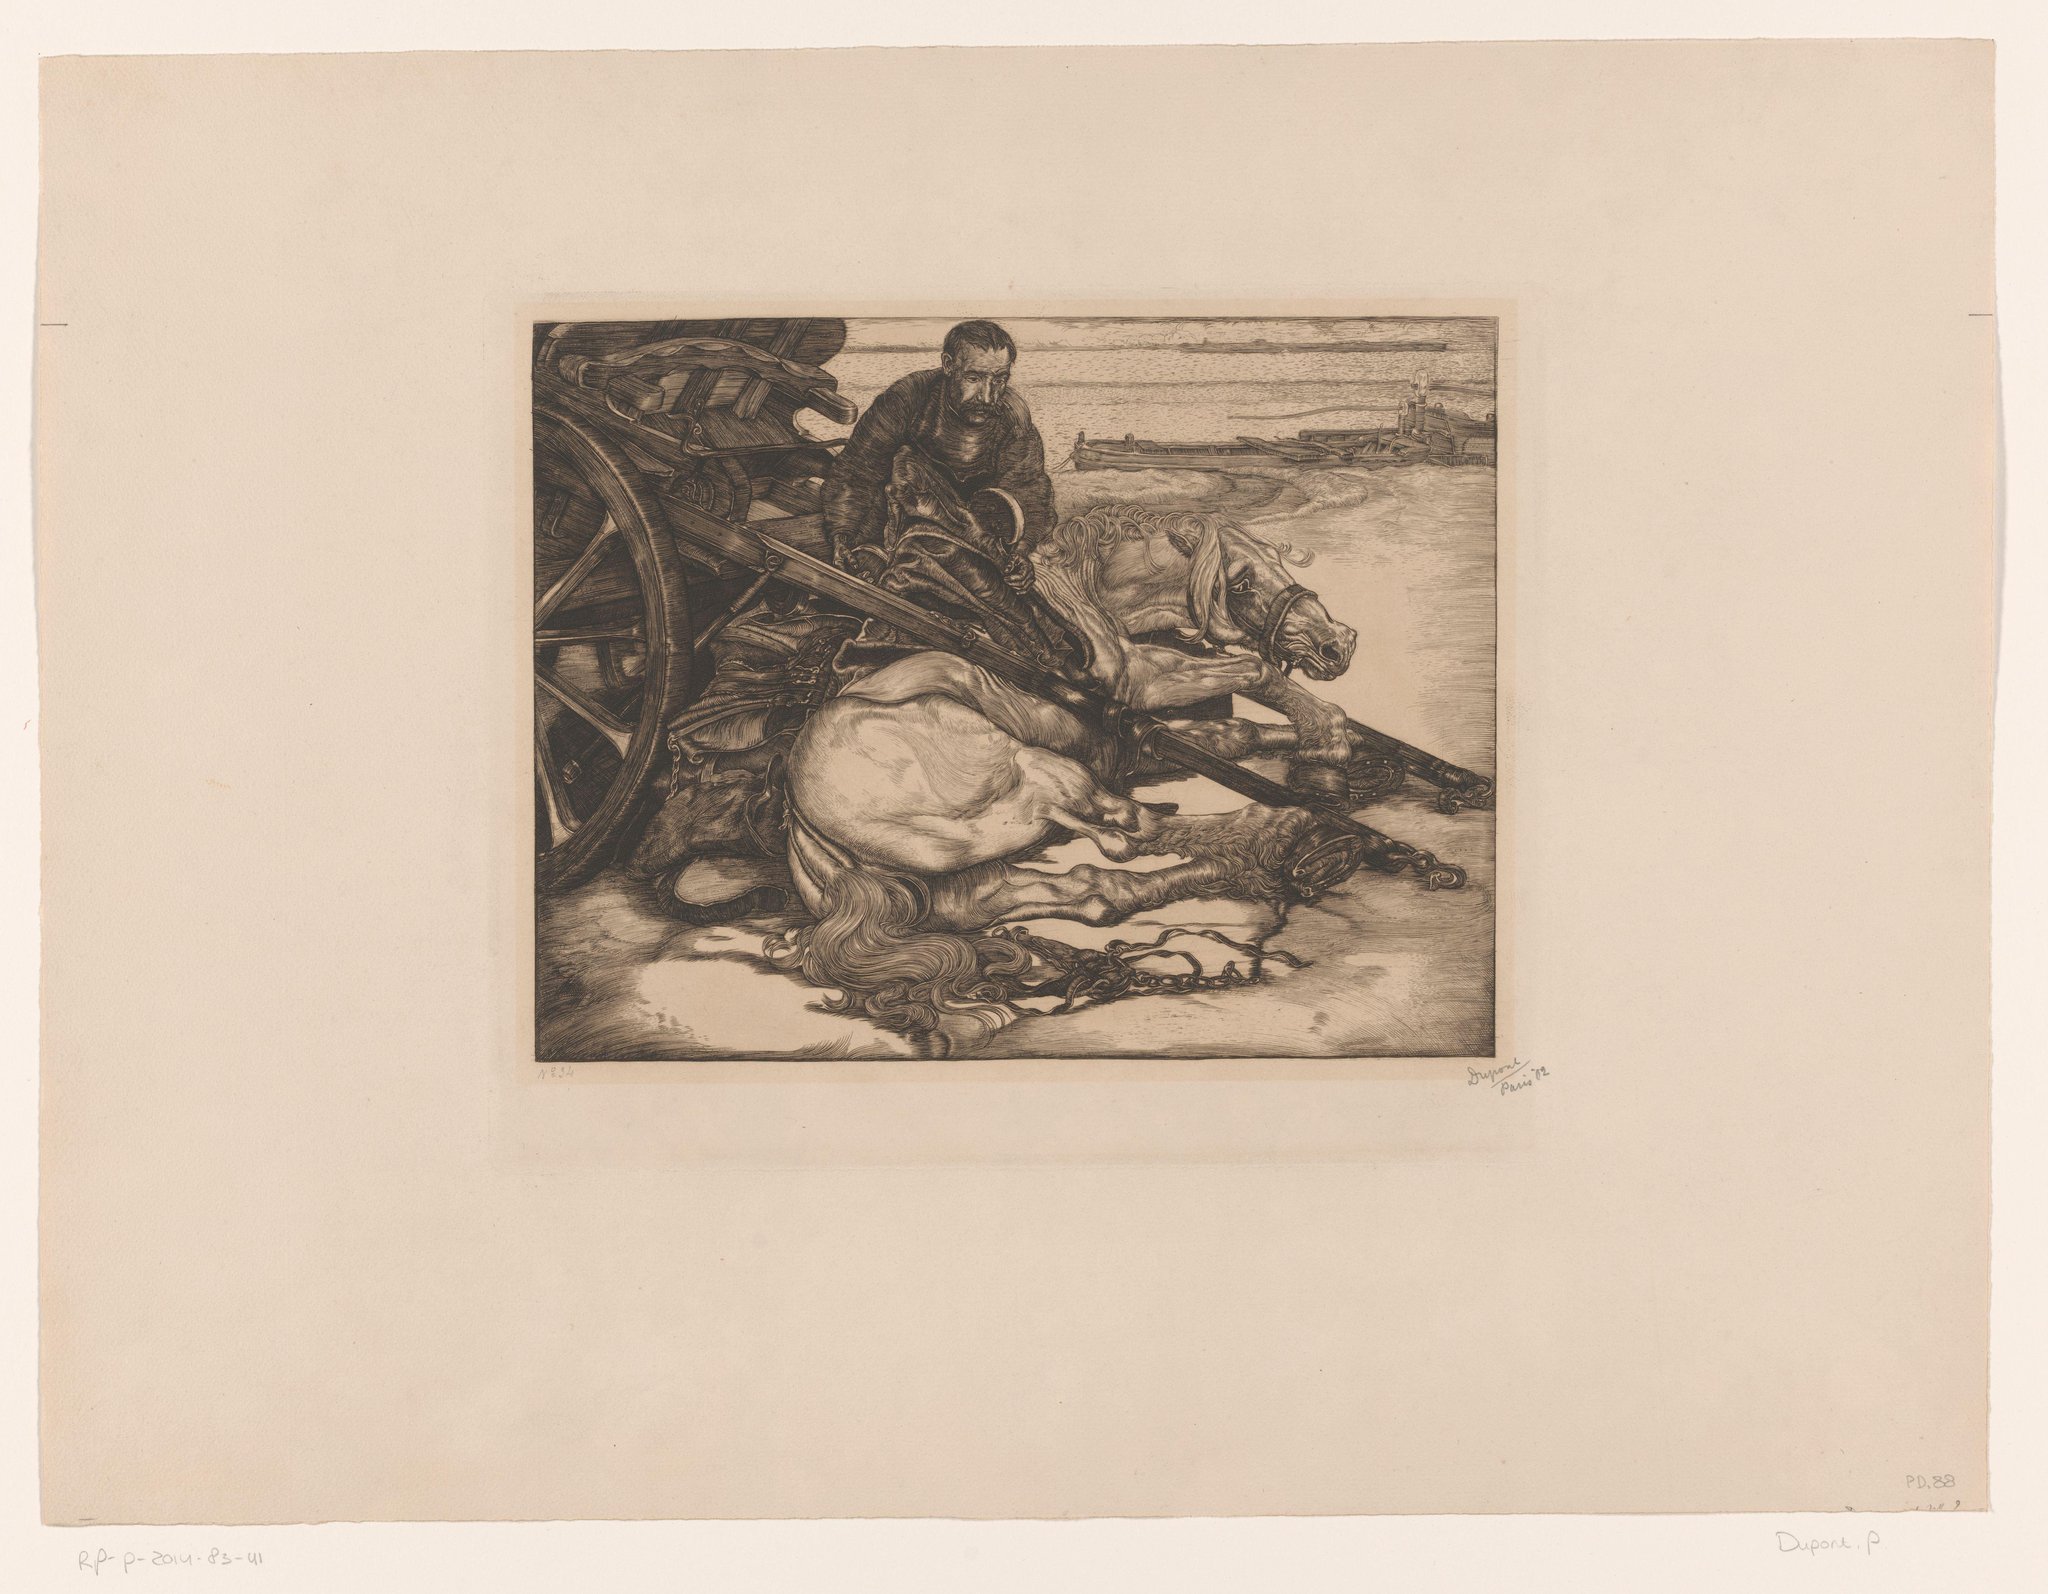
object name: print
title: Gewond trekpaard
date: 1902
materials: paper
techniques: engraving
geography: paris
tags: horse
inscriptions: collector's mark: ‘eigendom D. Harting, Heemstede’, collector's mark: Lugt 2228, inscription: ‘No. 34’